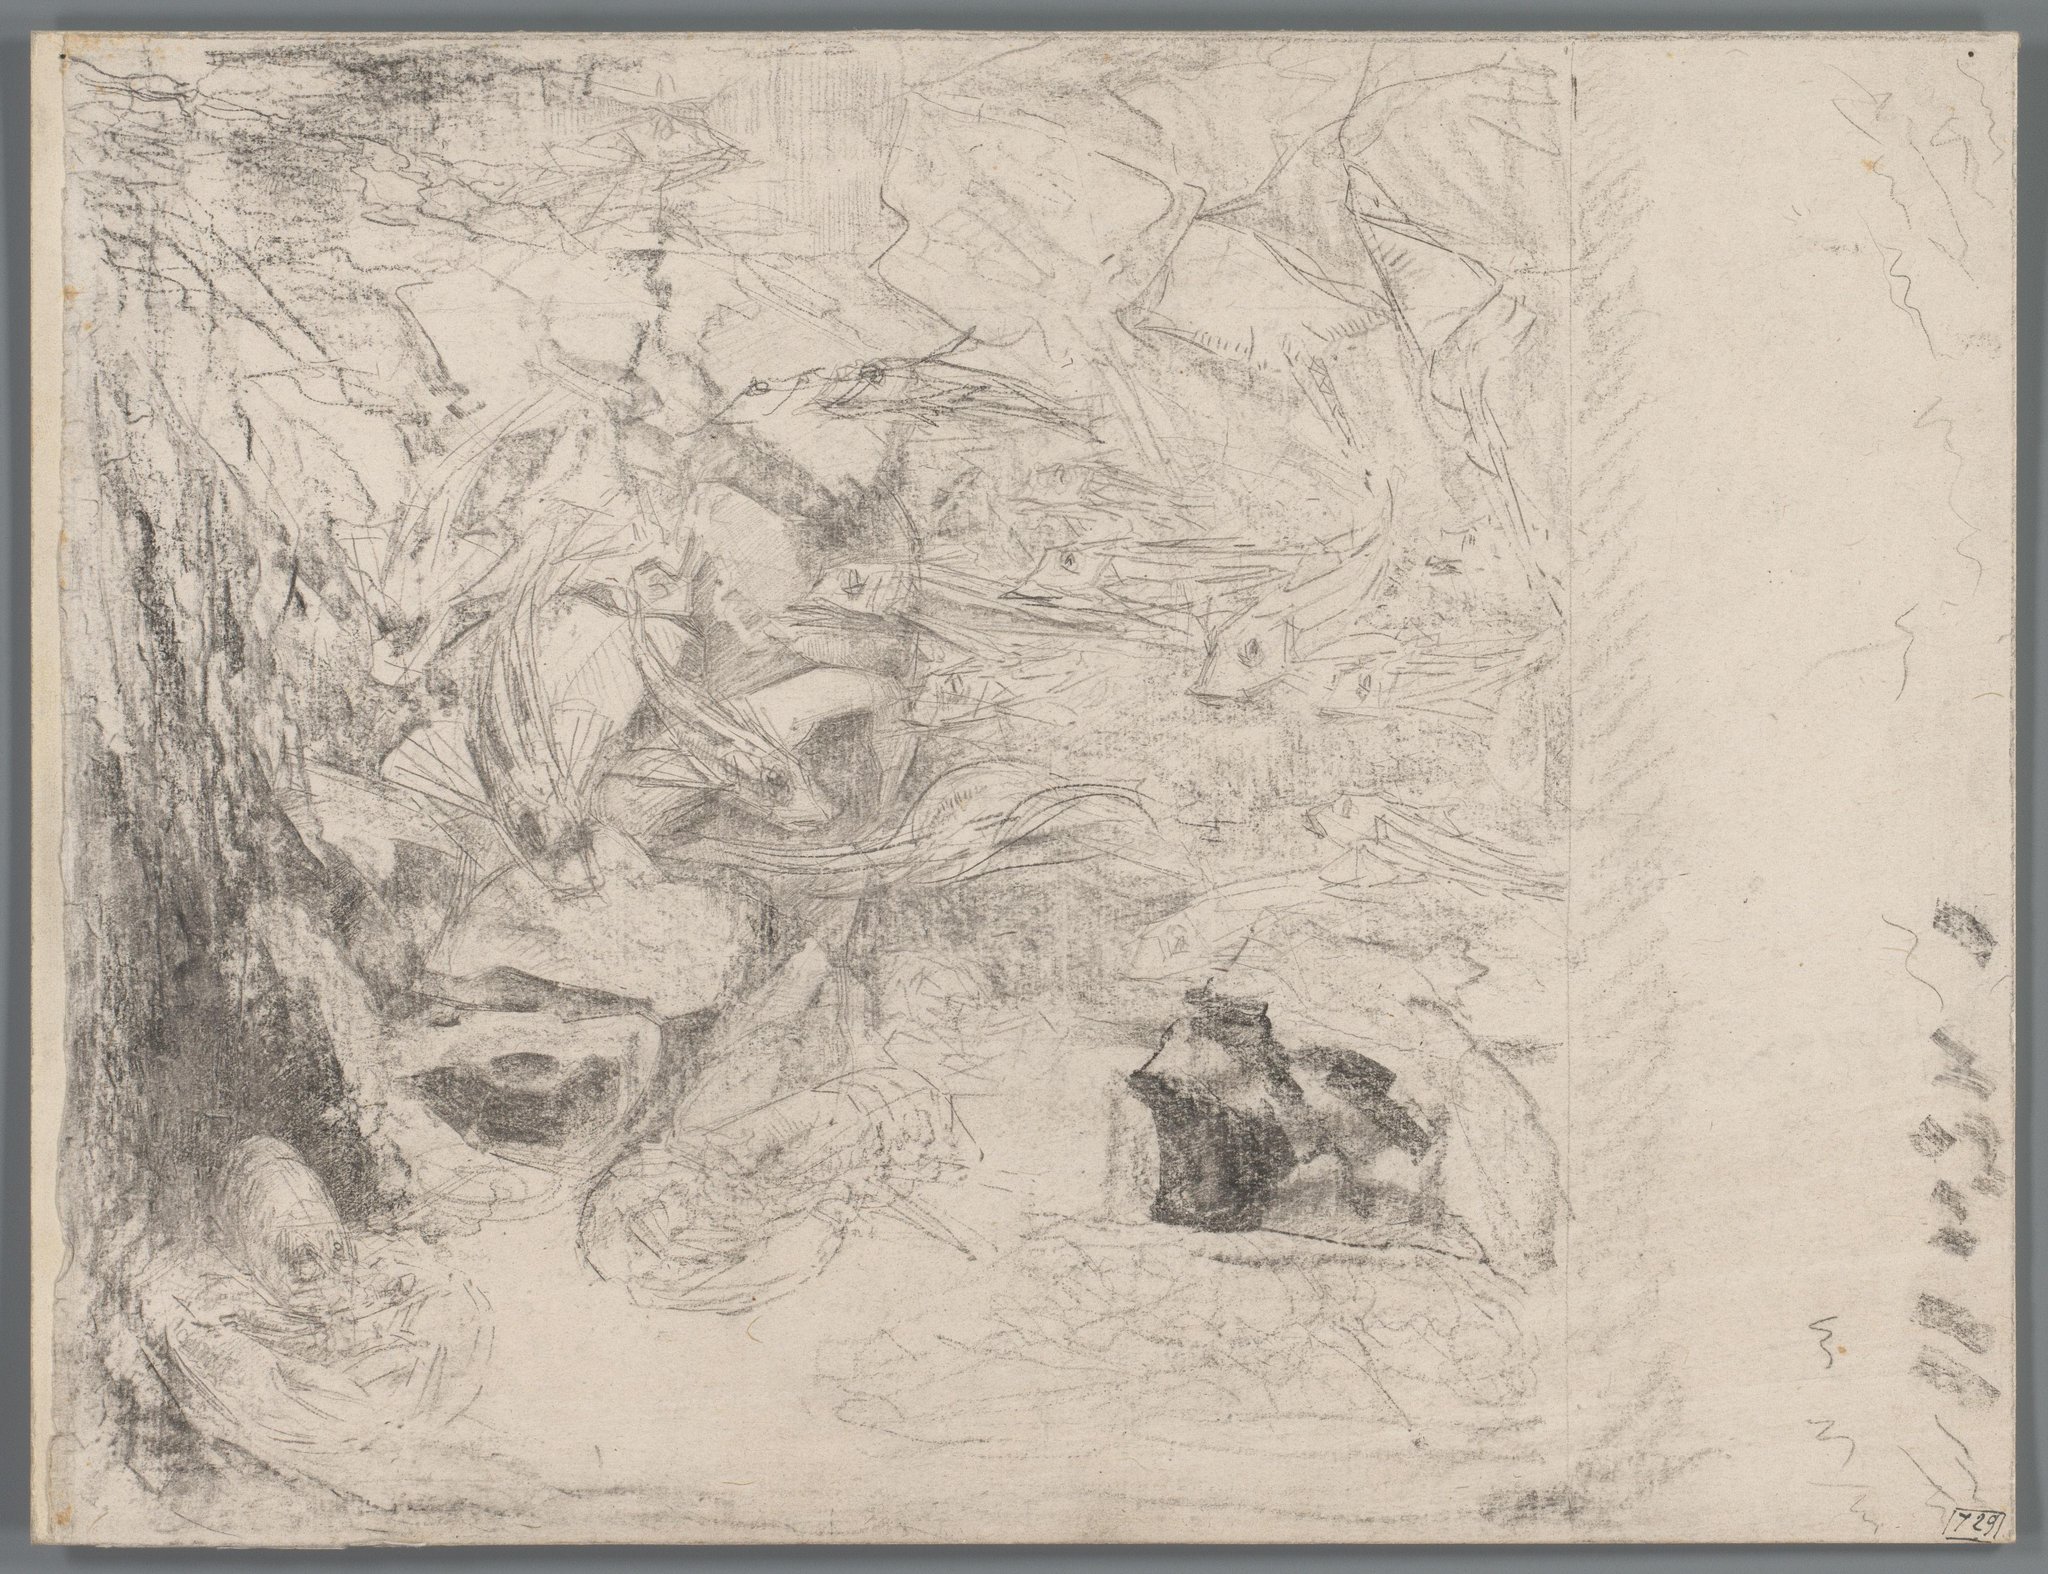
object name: drawing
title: Studie van een aquarium met rode ponen en kreeften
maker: gerrit willem dijsselhof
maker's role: designer, draughtsman, print maker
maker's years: 1866-1924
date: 1876-1924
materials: cardboard, chalk, paper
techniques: pasting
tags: aquarium, crustaceans: lobster, bony fishes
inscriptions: number: ‘729’